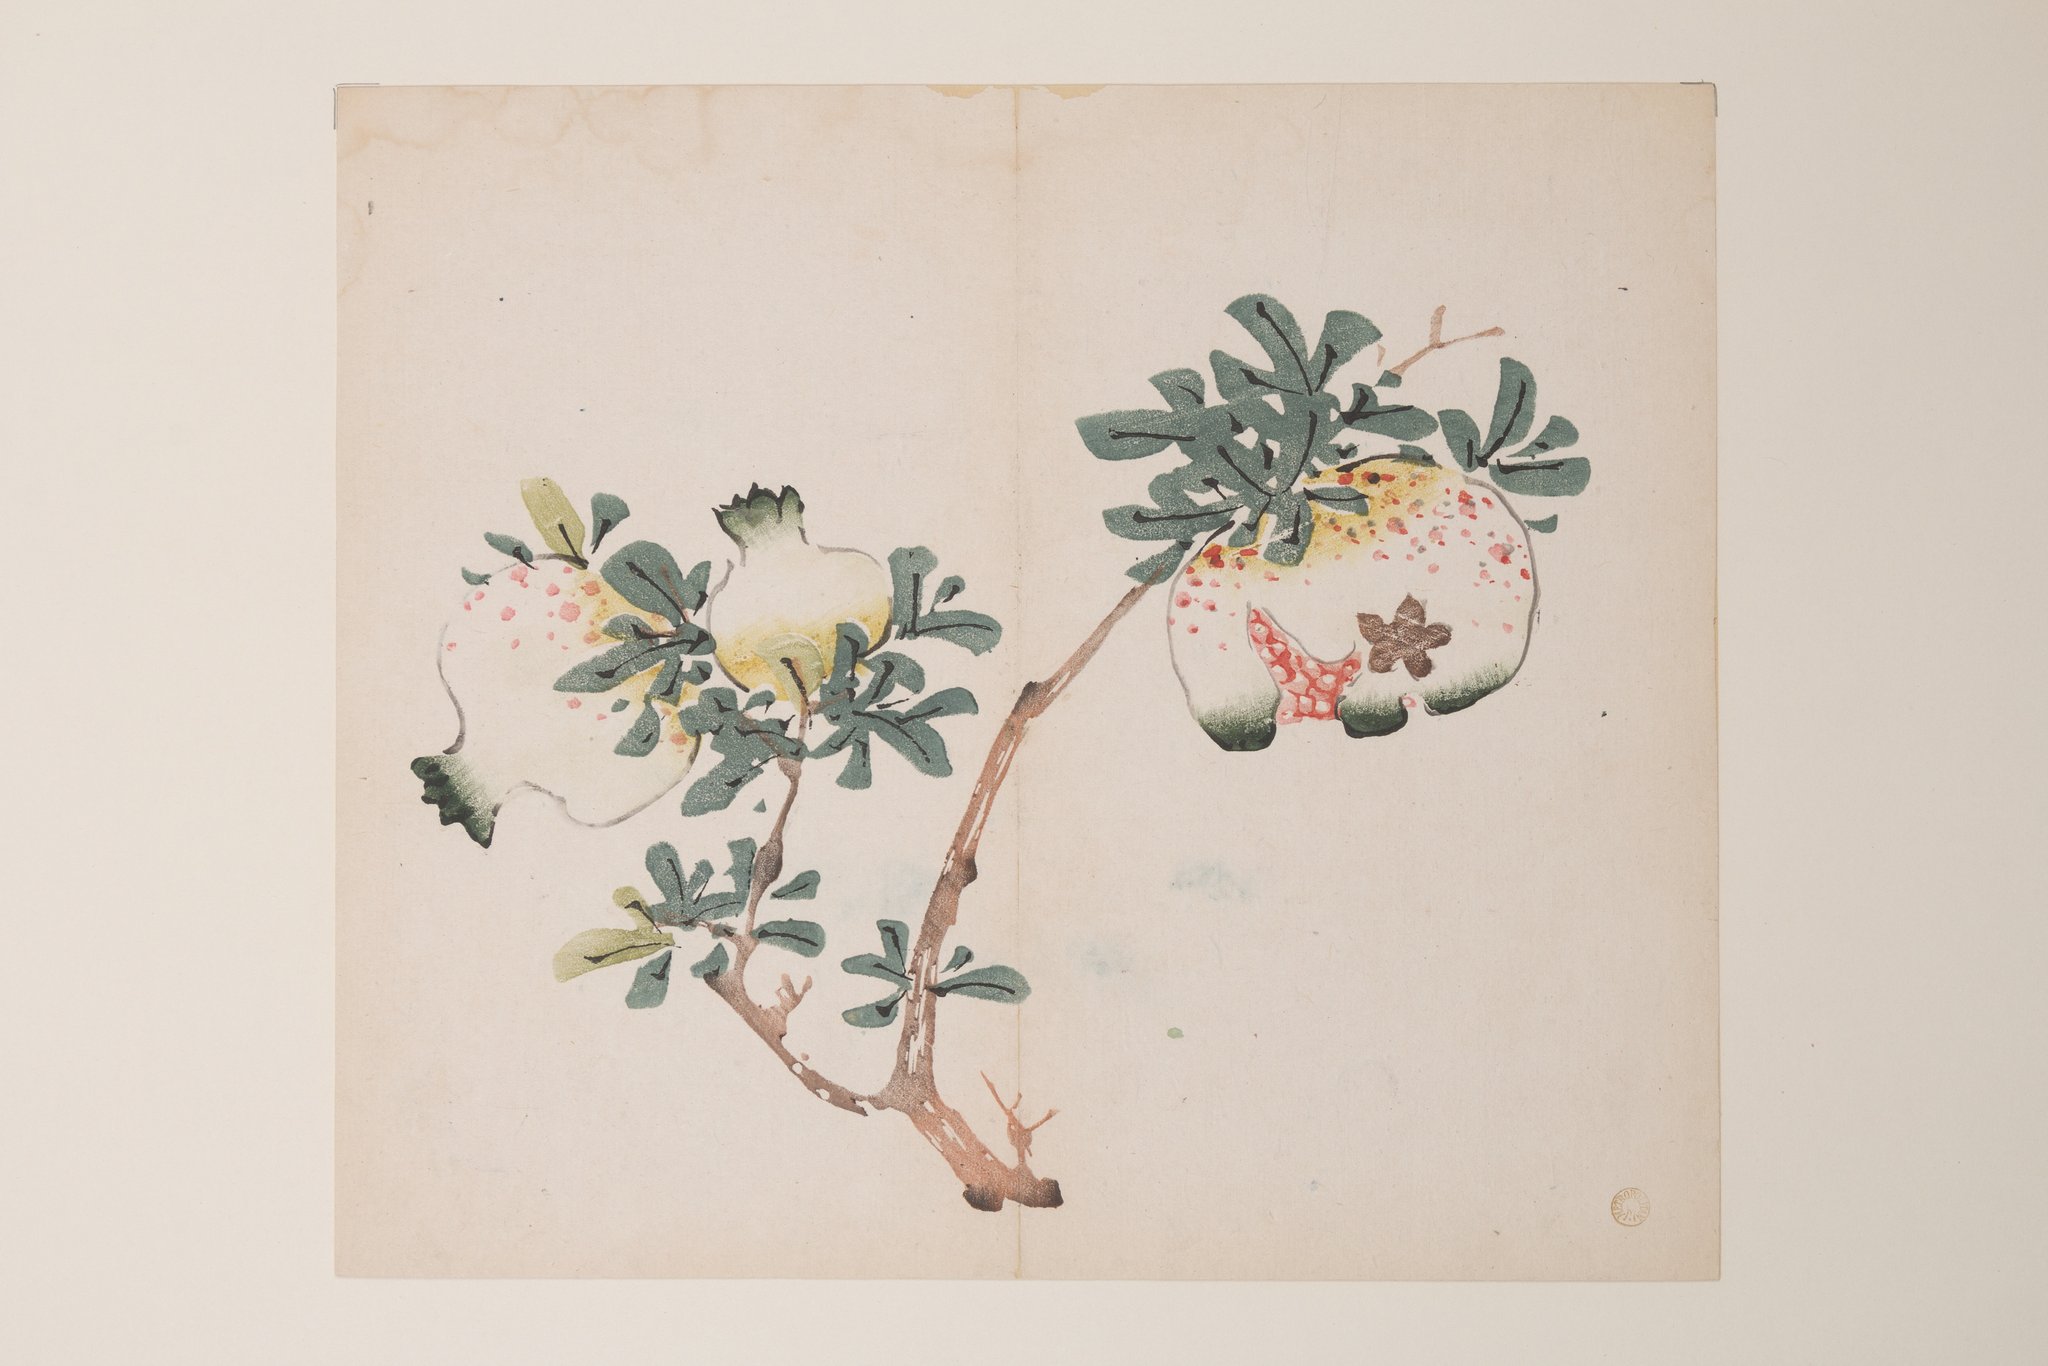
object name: print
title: Page from the Ten Bamboo Studio Manual of Painting and Calligraphy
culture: chinese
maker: hu zhengyan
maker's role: artist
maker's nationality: chinese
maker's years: 1584-1634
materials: ink, paper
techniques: printing